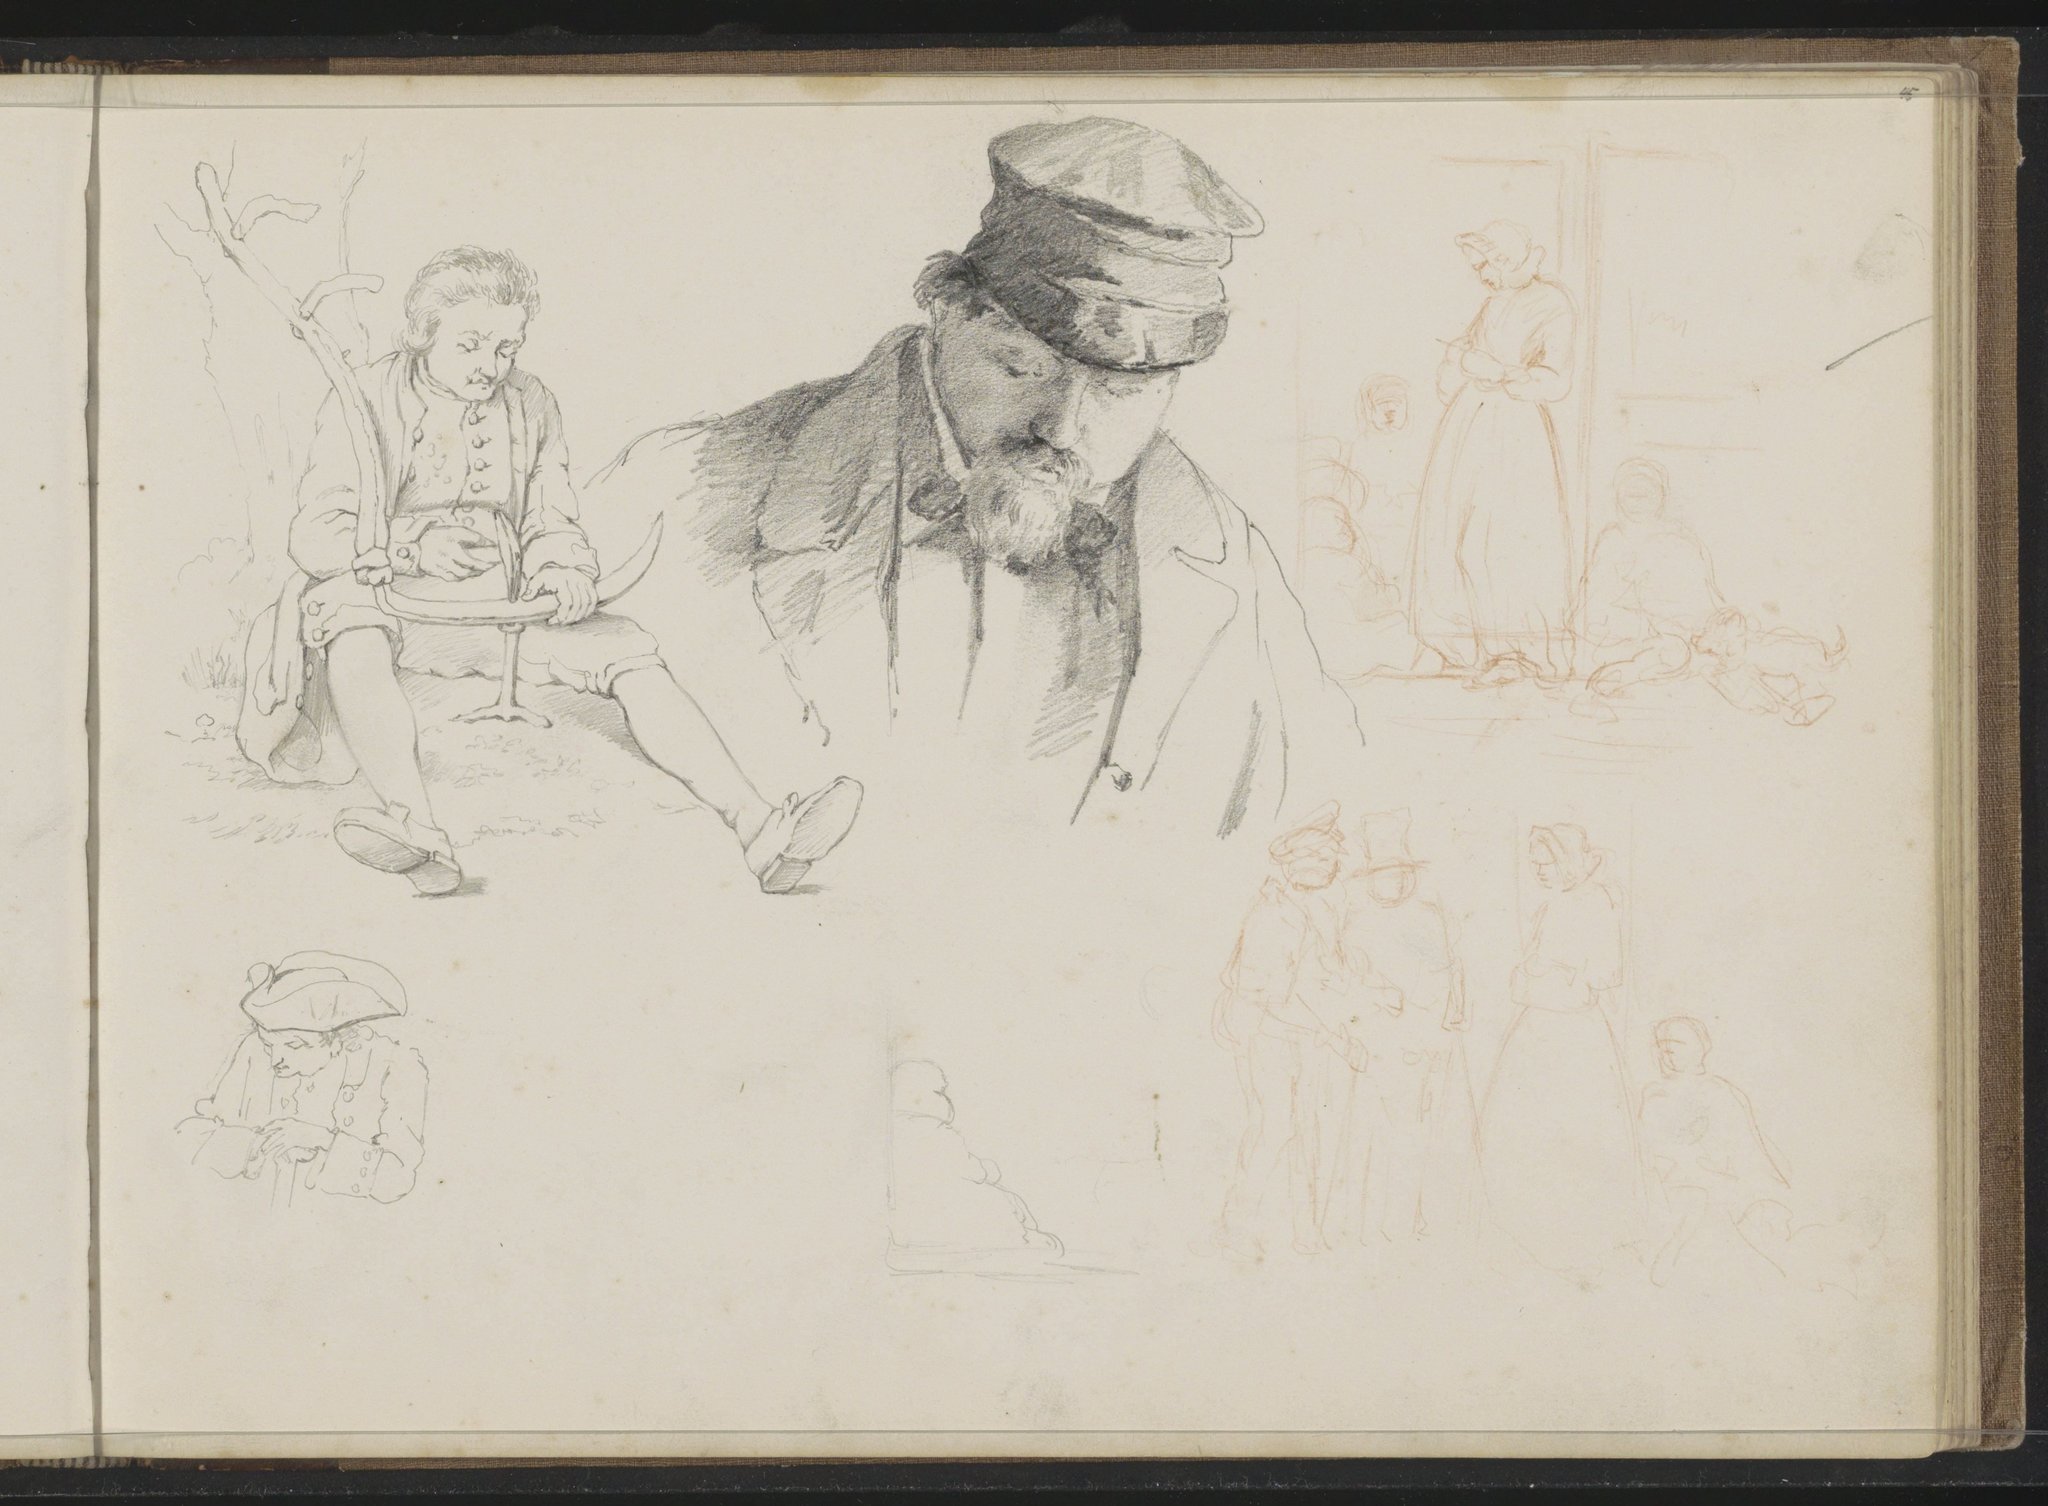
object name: sketchbook leaf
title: Studieblad met mannen en figuren bij een deuropening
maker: hendrik valkenburg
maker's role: draughtsman, painter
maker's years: 1826-1896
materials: chalk, paper, pencil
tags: tools, aids, implements ~ crafts and industries: hammer, (military) uniforms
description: Onder andere studies van een hamerende man en een man in militair uniform met een steek. Blad 45 recto uit een schetsboek met 77 bladen.